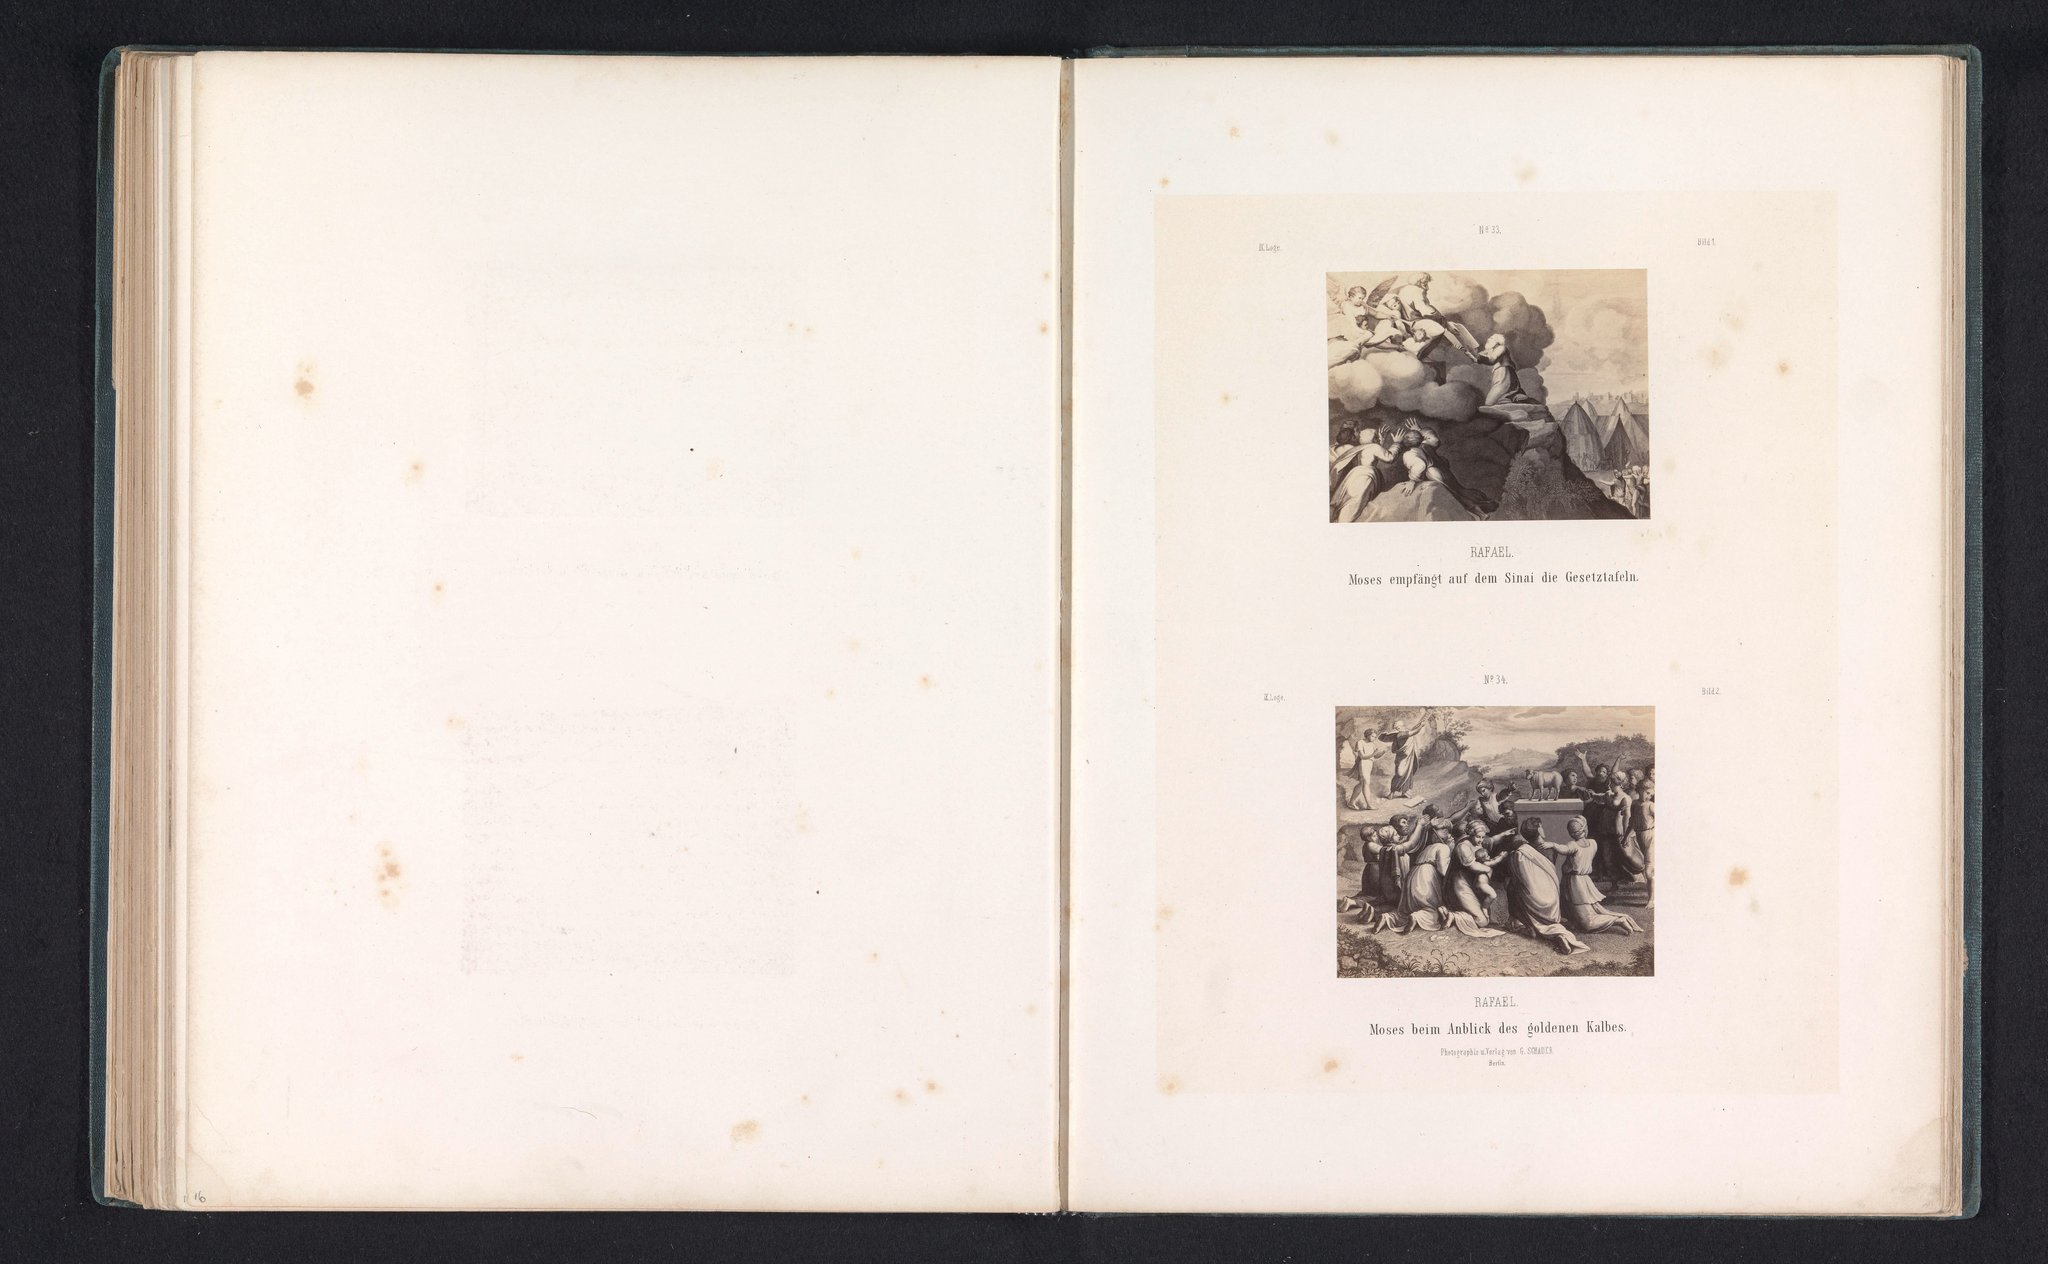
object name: page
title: Fotoreproducties van prenten naar fresco's met voorstellingen van Moses die de tien geboden ontvangt en het gouden kalf aanschouwt door Rafaël voor de loggia's in het Vaticaan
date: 1851-1861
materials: photographic support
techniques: albumen print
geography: berlin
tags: adoration of the golden calf (which may be standing on a pillar, and is sometimes depicted as a dragon), moses receives the tables of the law from god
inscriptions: number: ‘No 33. No 34. Bild 1. Bild 2. IX. Loge.’